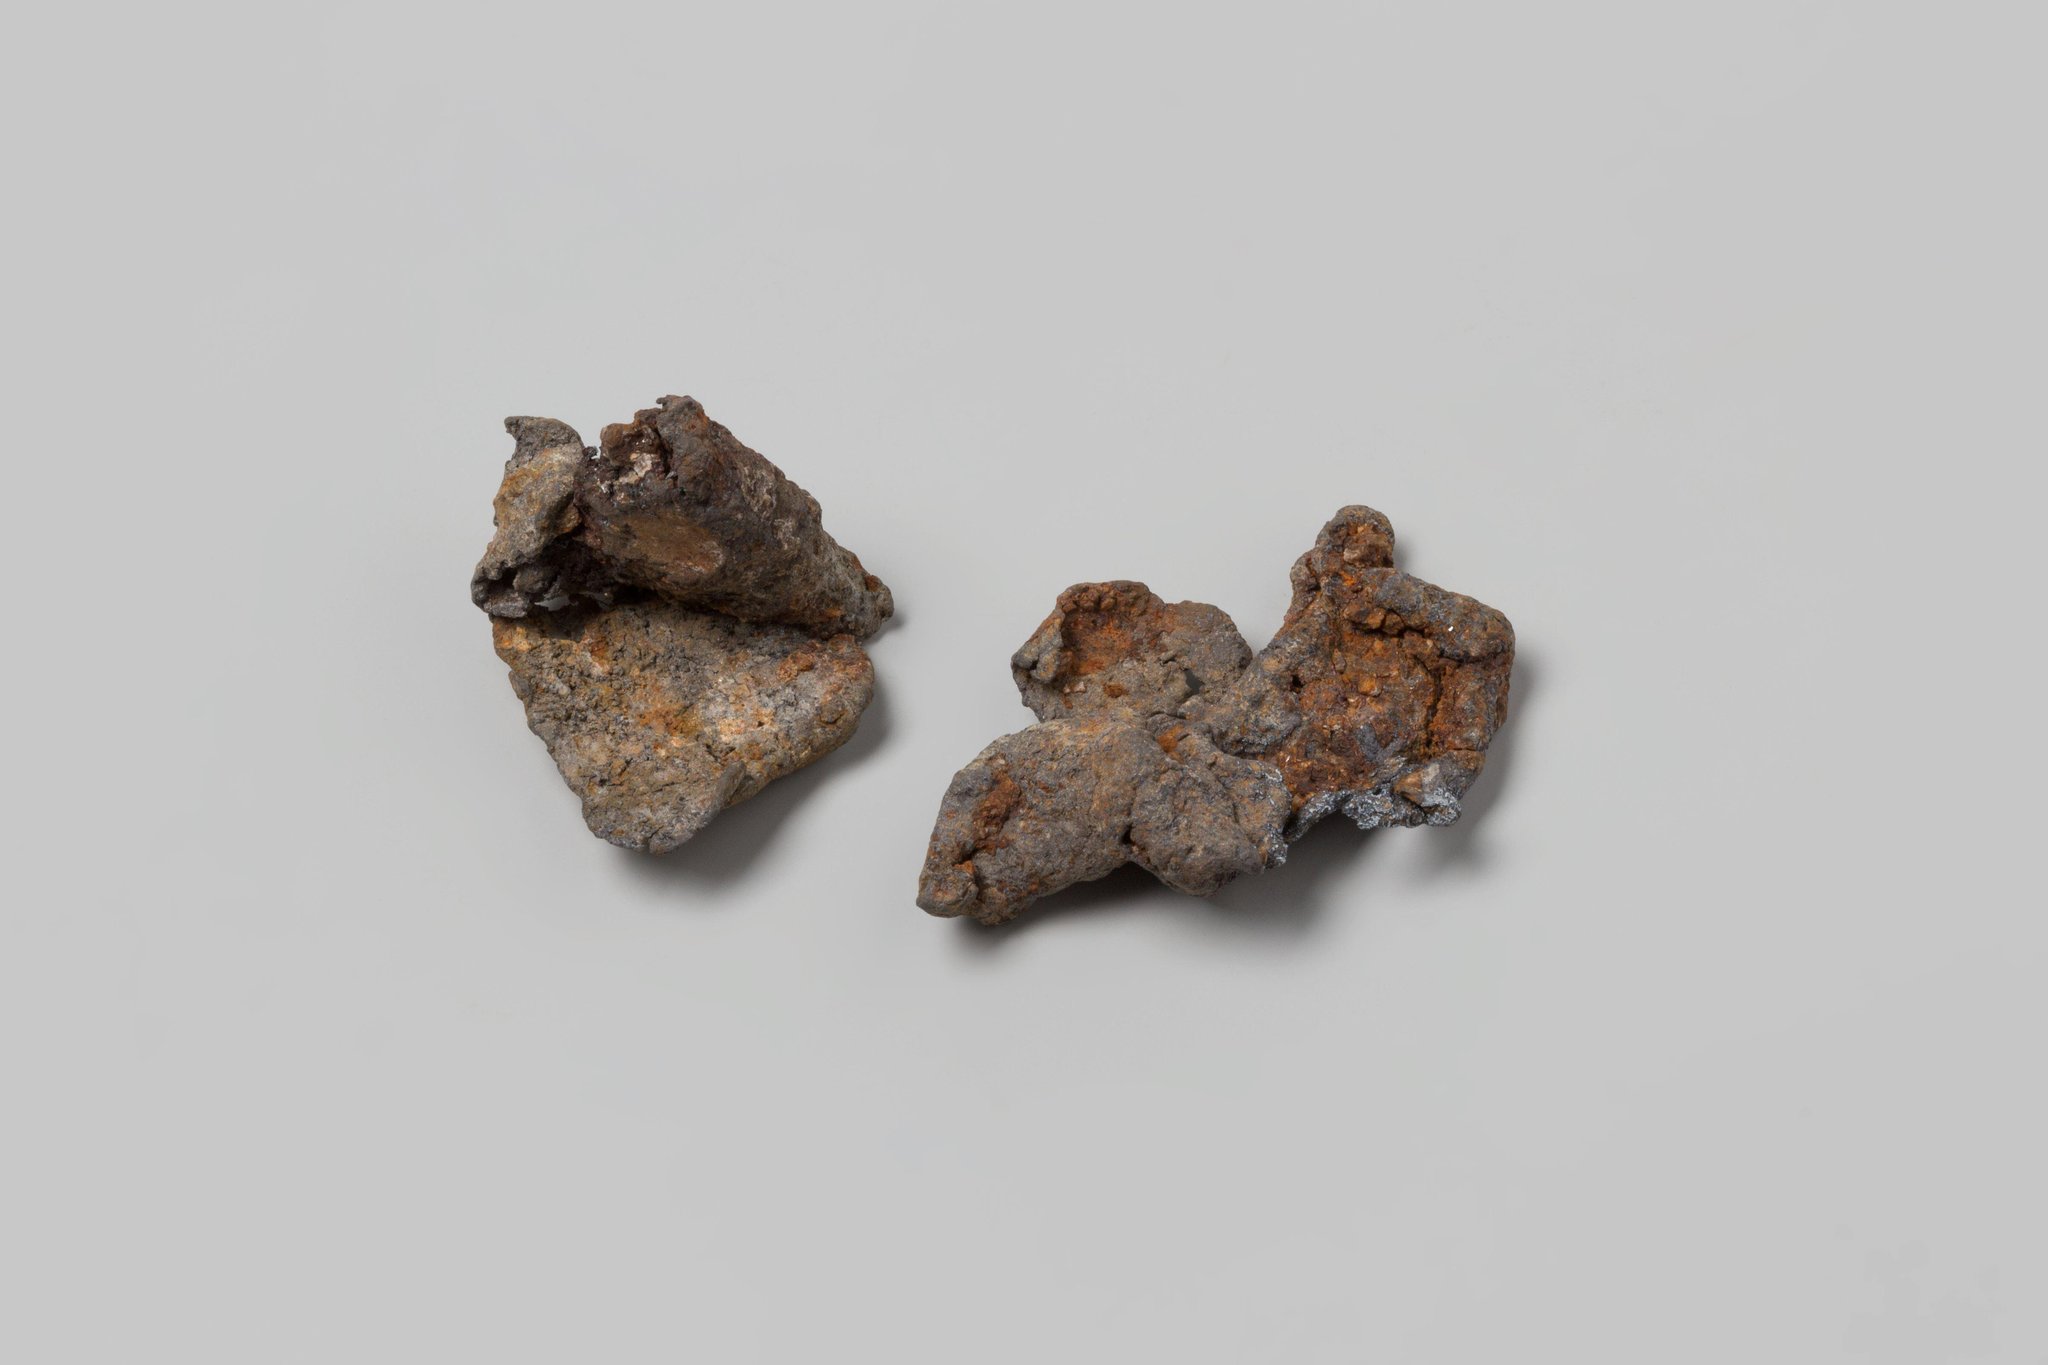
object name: scheepswrakvondst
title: Fragmenten lood uit het wrak van de Oost-Indiëvaarder Hollandia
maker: Anonymous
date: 1700-1743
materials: lead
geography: netherlands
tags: verenigde oostindische compagnie, hollandia (schip), annet